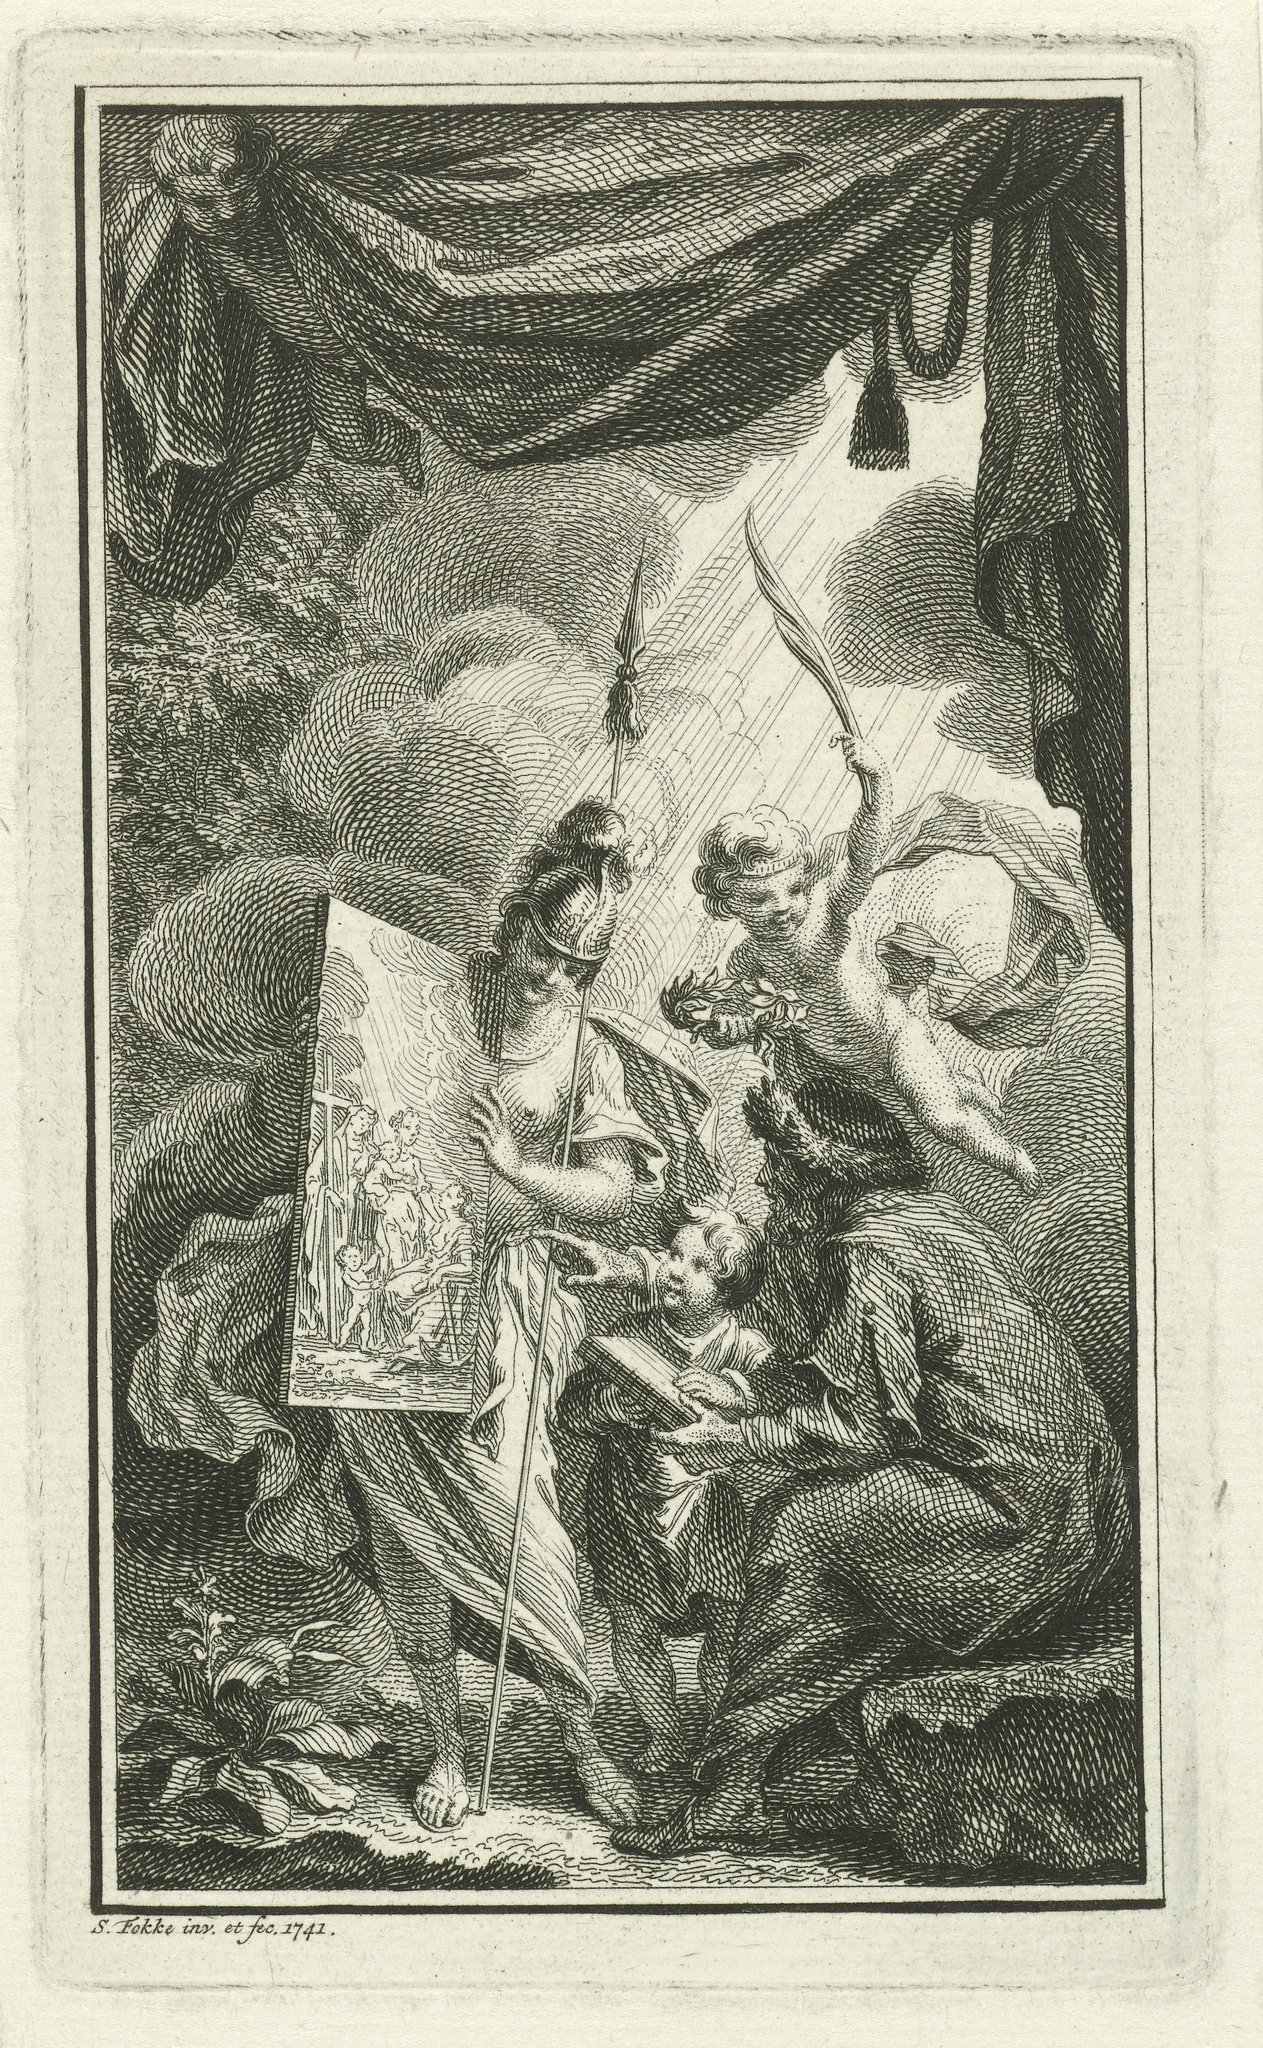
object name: print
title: Minerva toont een schilderij van de Heilige Familie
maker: simon fokke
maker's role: draughtsman, print maker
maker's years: 1712-1784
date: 1741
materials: paper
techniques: etching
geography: amsterdam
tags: angels crowning and/or bringing palm-branches, (story of) minerva (pallas, athena), holy family, and derived representations, crowning with laurel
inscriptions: collector's mark: Lugt 240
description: Minerva toont een man en kind een schilderij van de Heilige Familie. Het kind houdt het boek vast dat de man in zijn handen heeft. De man wordt gelauwerd door een putto met palmtak.